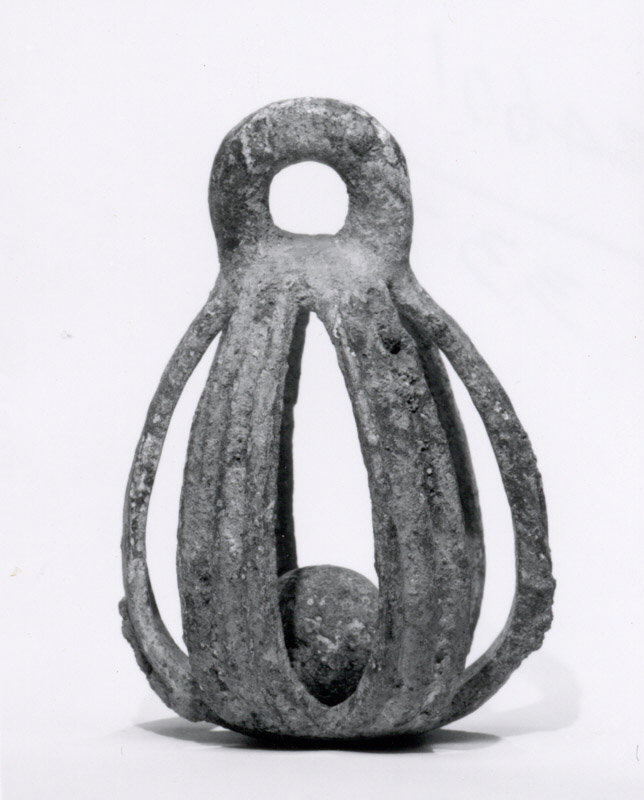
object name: rattle bell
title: Openwork rattle bell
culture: iranian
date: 900-701 BCE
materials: bronze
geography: western iran